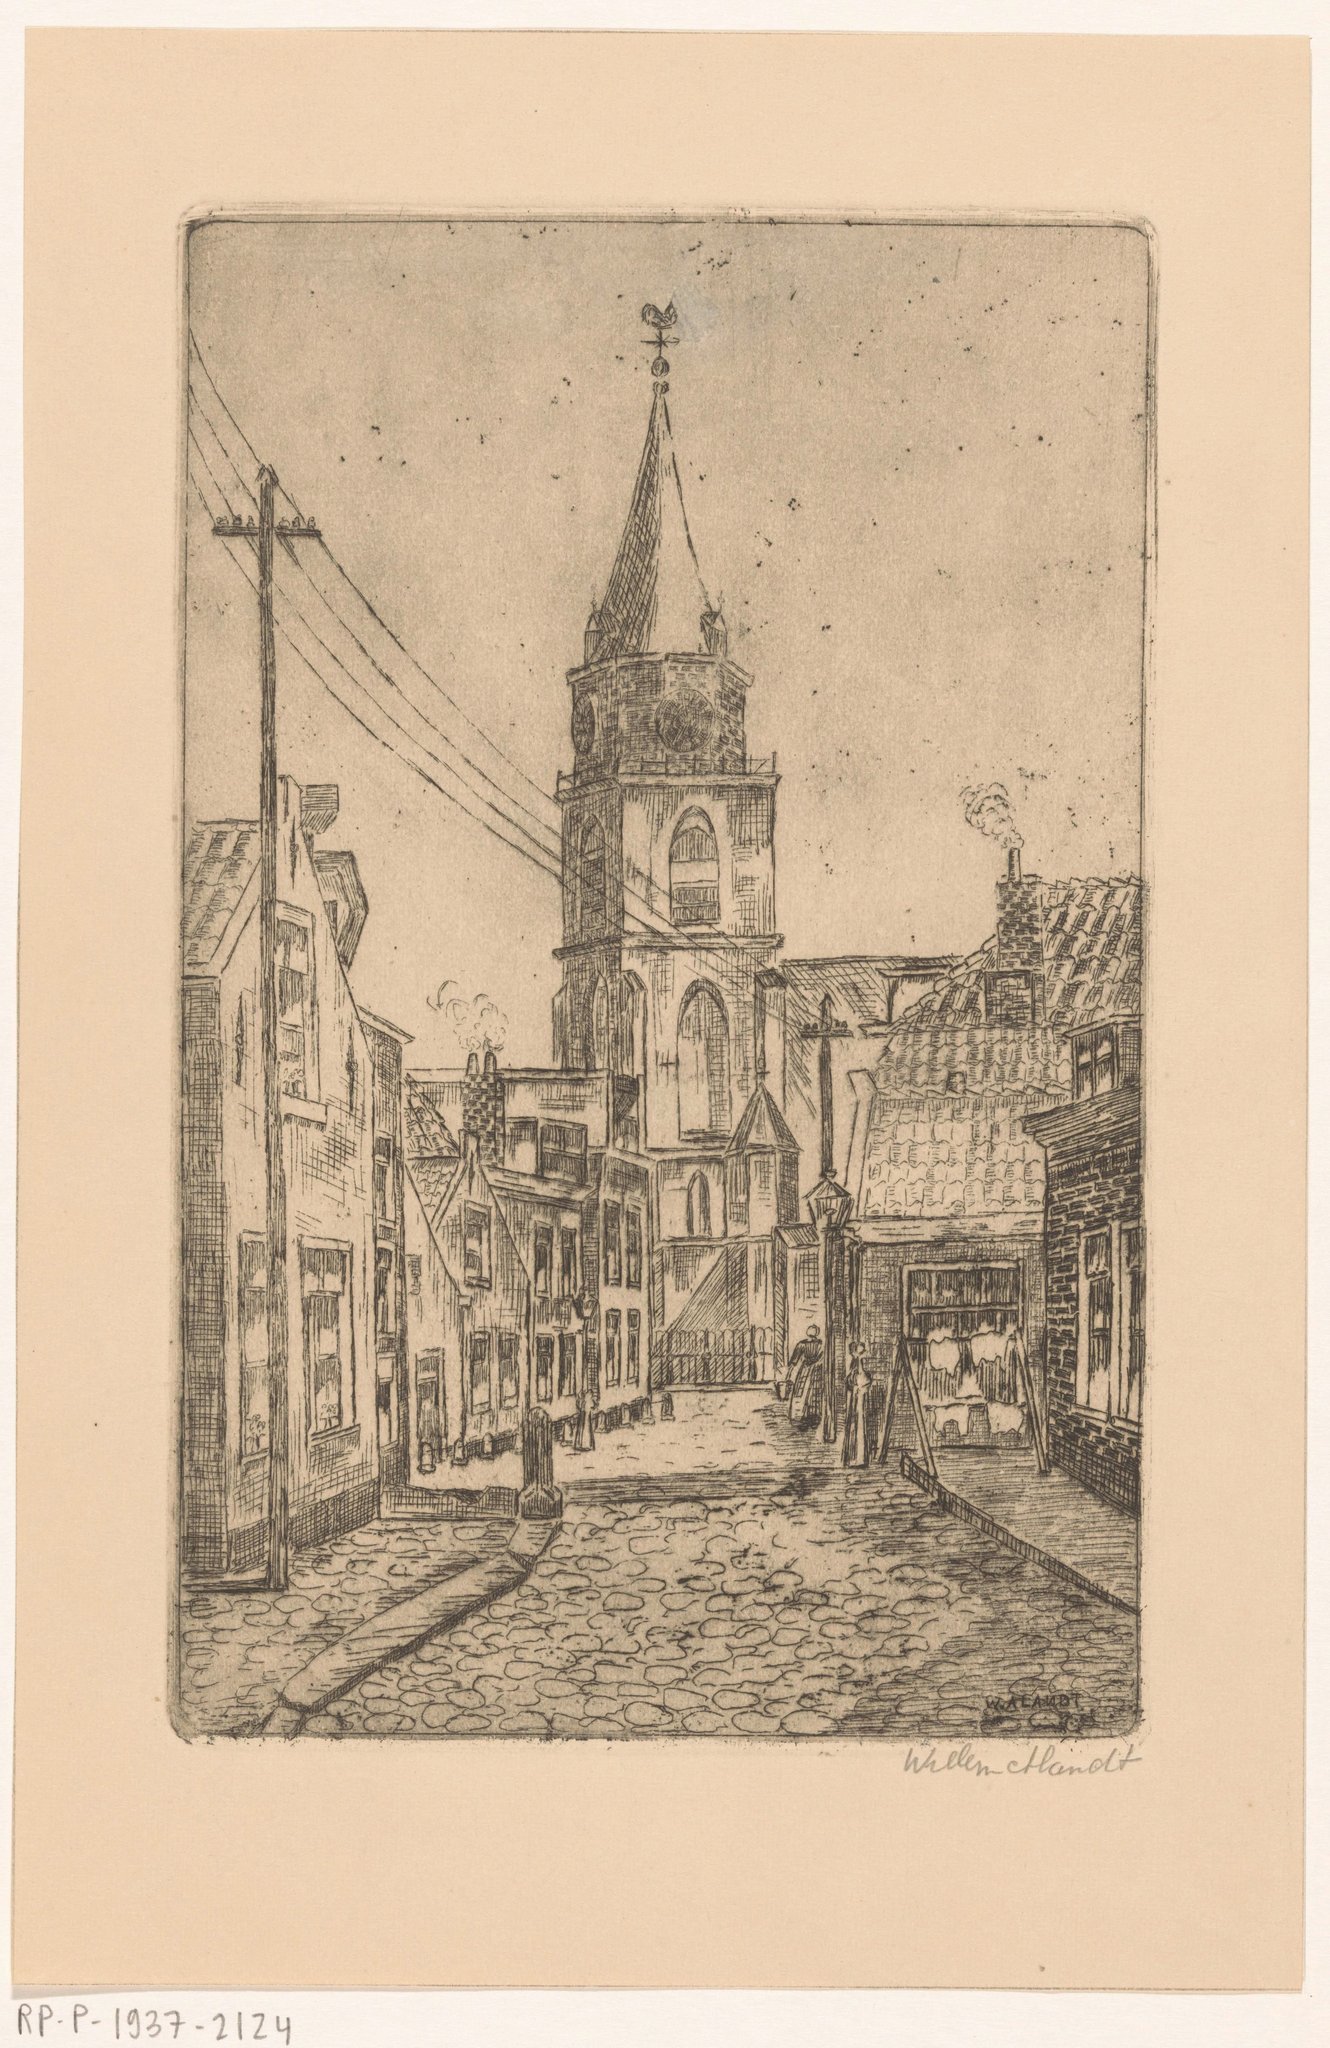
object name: print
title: Stadsgezicht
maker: wilhelmus franciscus marsman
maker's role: draughtsman, painter, print maker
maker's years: 1899-1924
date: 1909-1924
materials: paper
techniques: drypoint, etching, intaglio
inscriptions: collector's mark: Lugt 2228, signature: ‘Willem Alandt’, collector's mark: Lugt 2760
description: Straat met aan het einde een kerk, rechts een vrouw met een emmer en links elektriciteitsdraden.